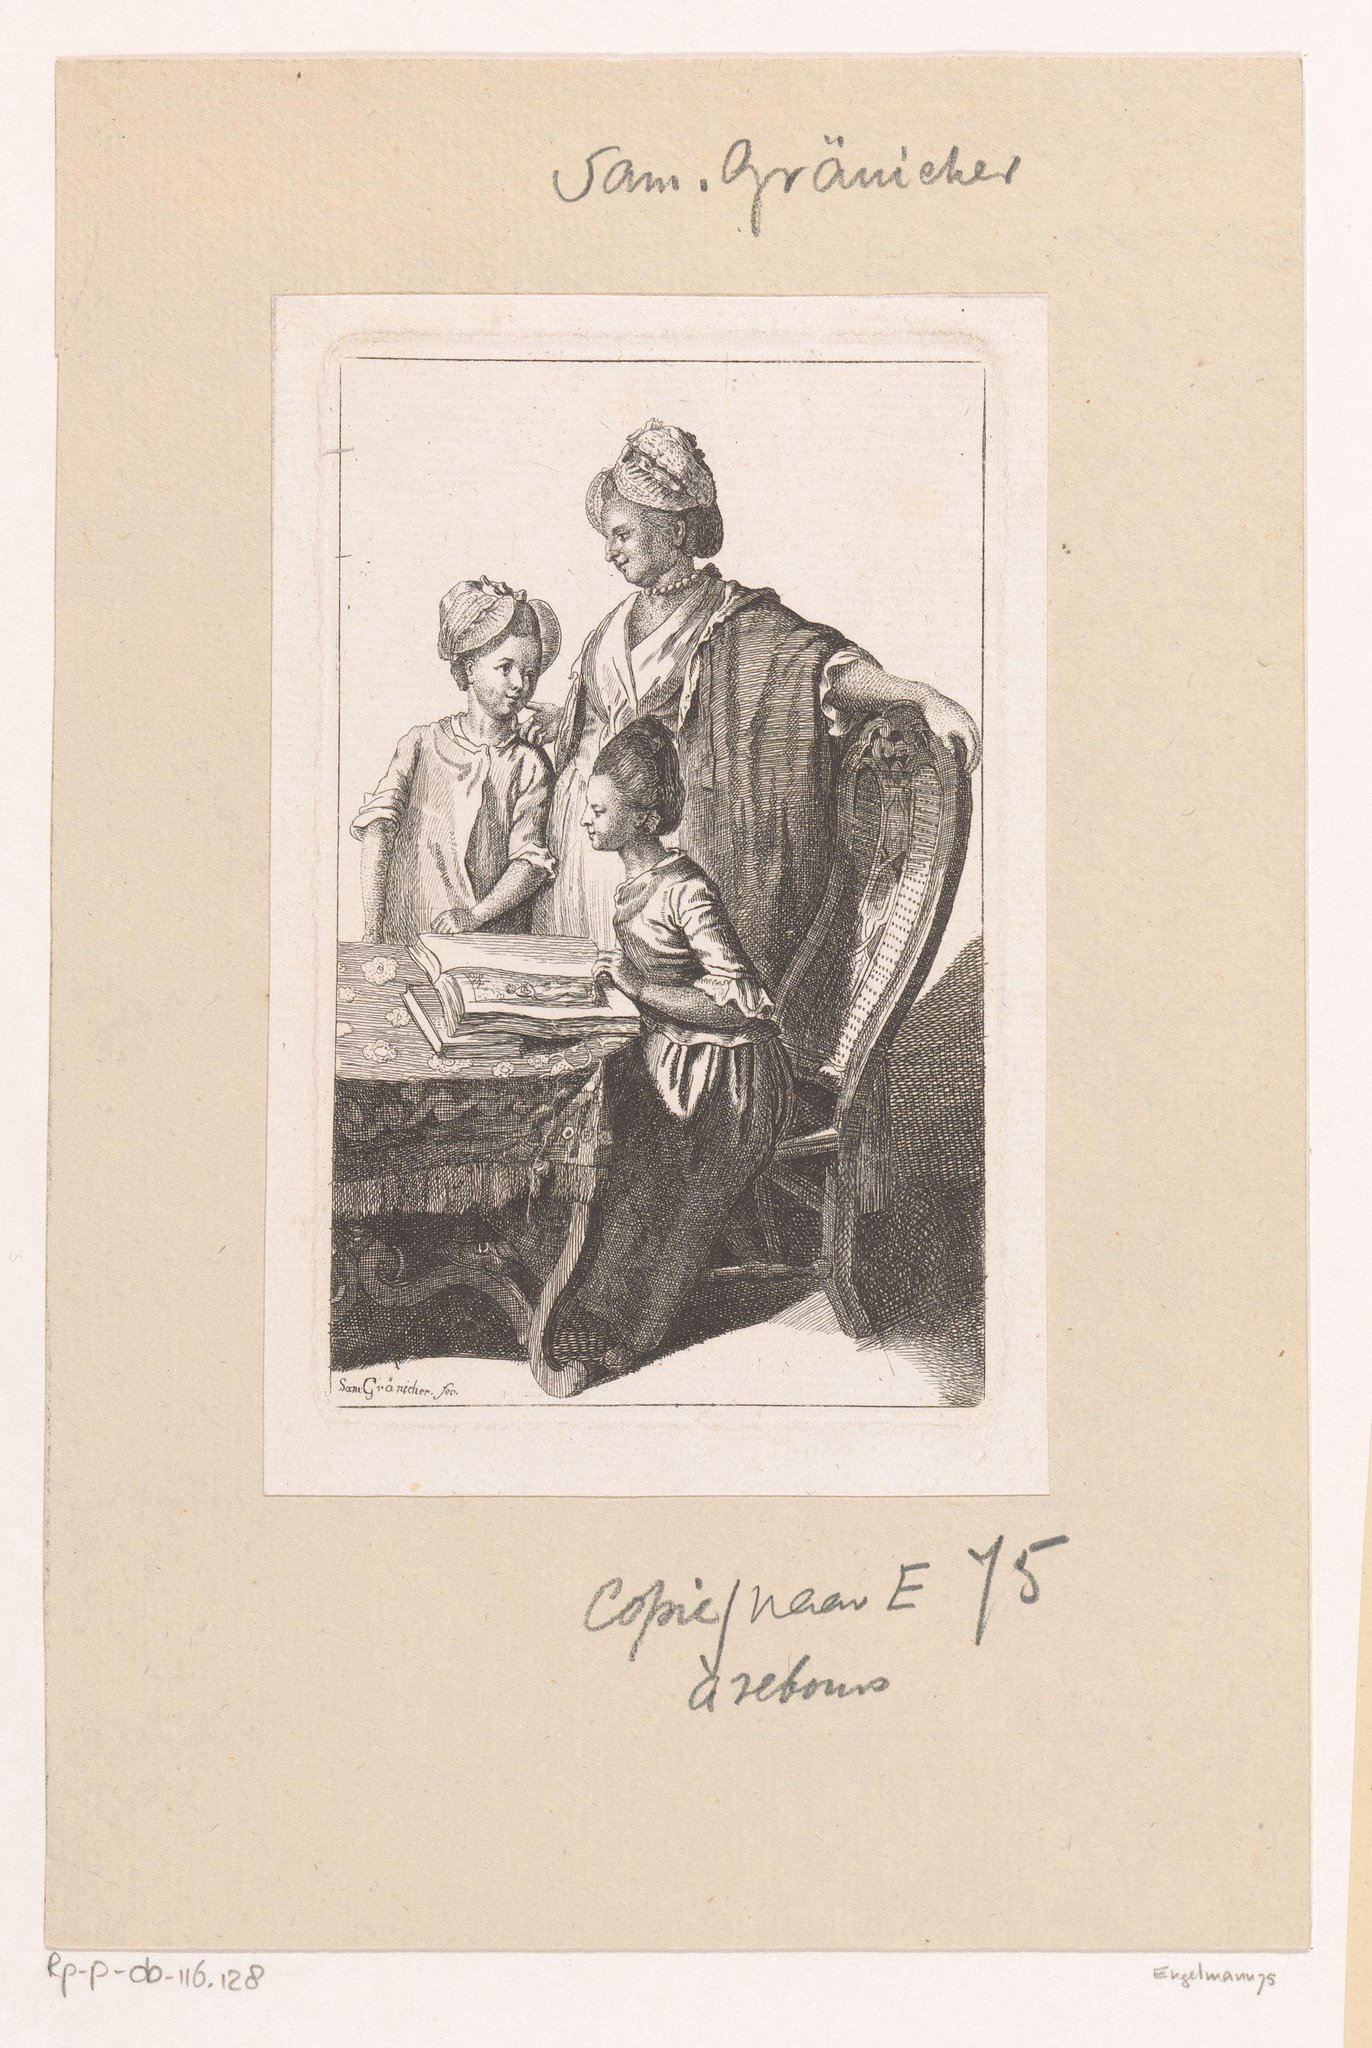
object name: print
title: Vrouw en kinderen van Daniel Nikolaus Chodowiecki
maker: samuel gränicher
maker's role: painter, print maker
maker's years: 1758-1813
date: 1768-1813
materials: paper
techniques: etching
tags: reading, mother and daughter(s) (family group)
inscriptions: collector's mark: Lugt 2228